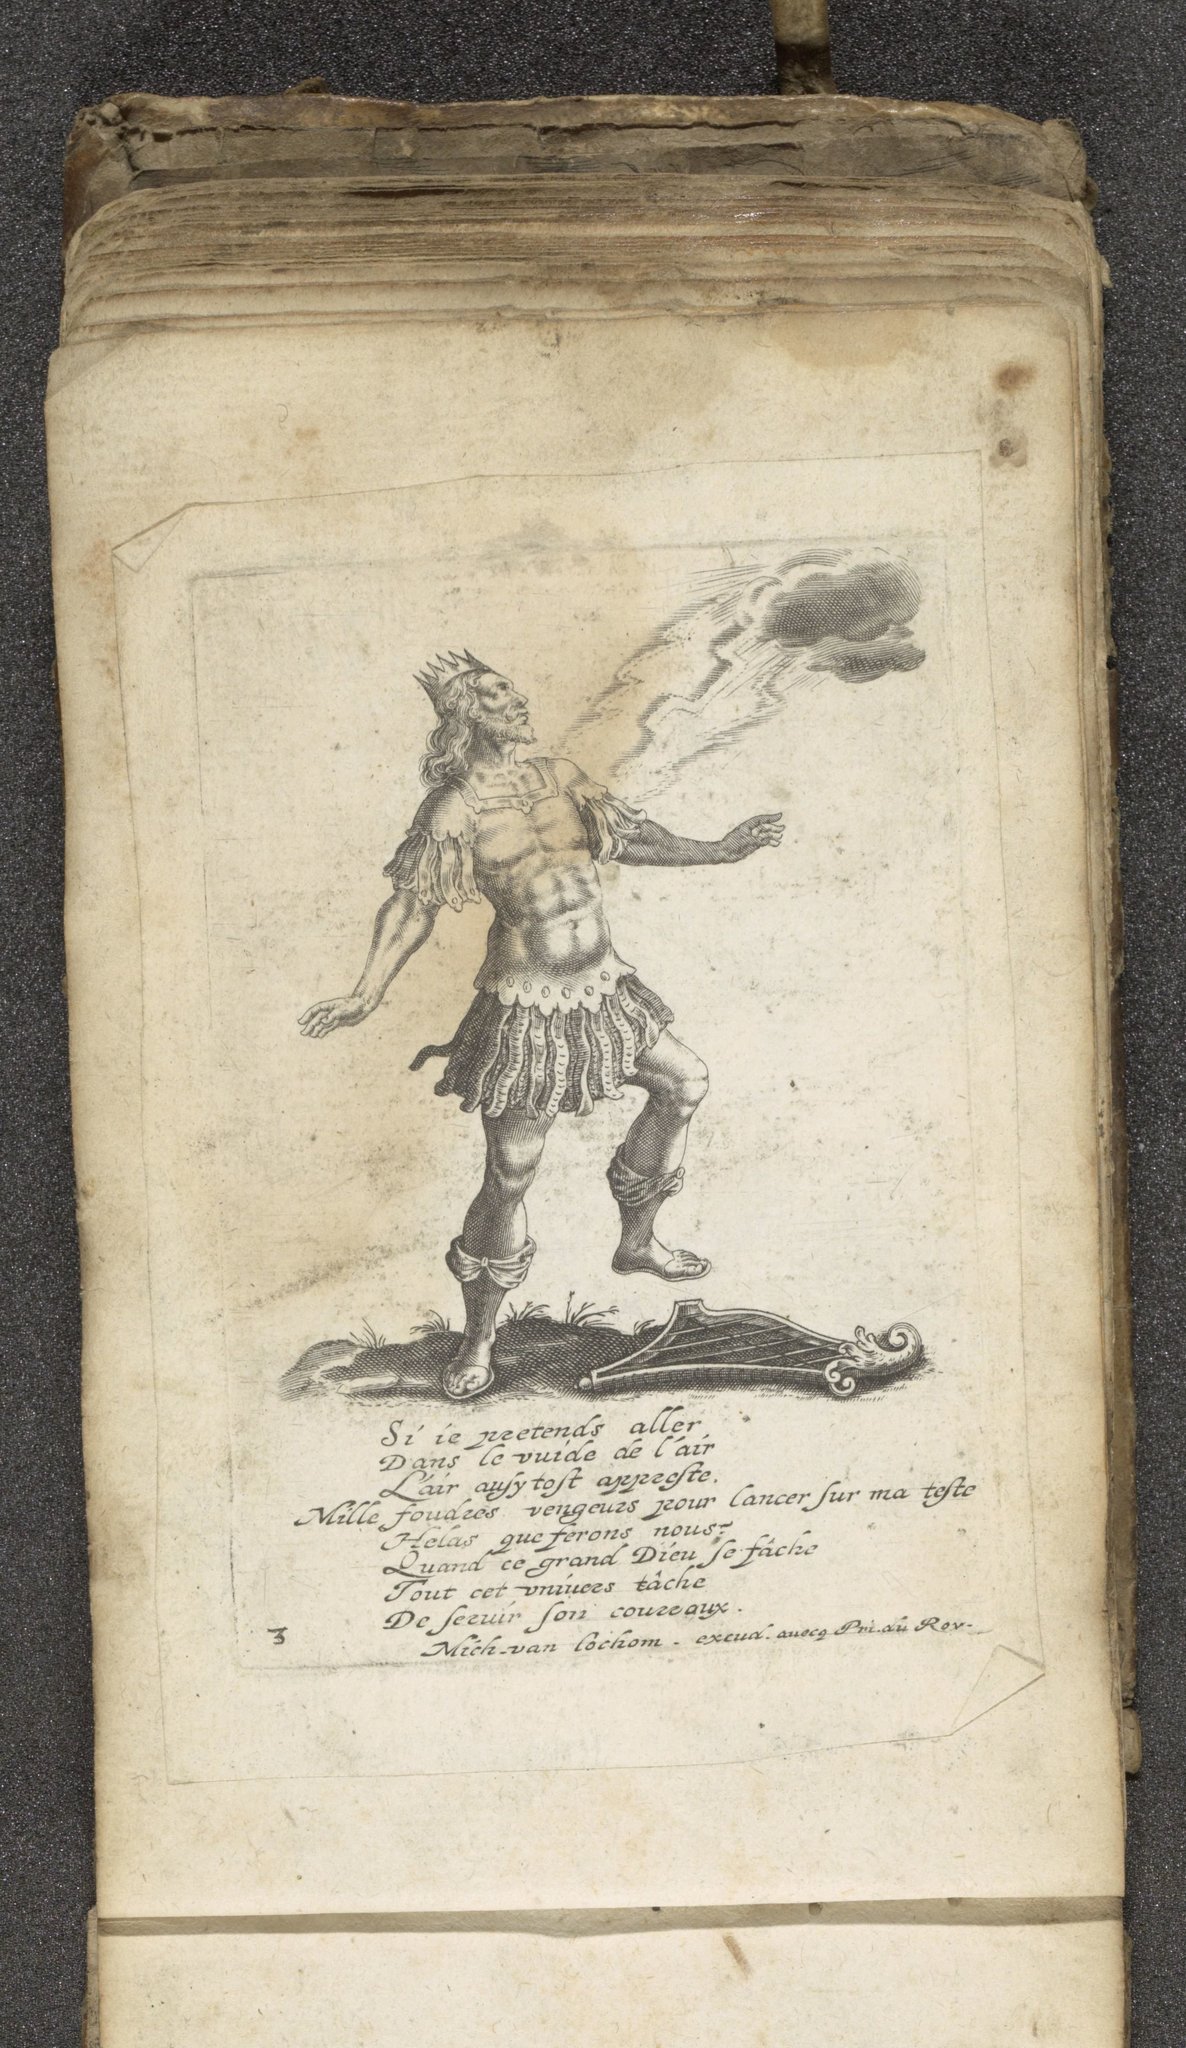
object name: print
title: David geraakt door de bliksem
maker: michel van lochom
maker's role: print maker, publisher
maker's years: 1601-1647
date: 1625-1647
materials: paper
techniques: engraving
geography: paris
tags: story of david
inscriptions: inscription: ‘74’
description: David wordt geraakt door de bliksem. Op de grond naast hem ligt zijn harp. Onder de voorstelling acht regels tekst in het Frans. De prent maakt deel uit van een album.